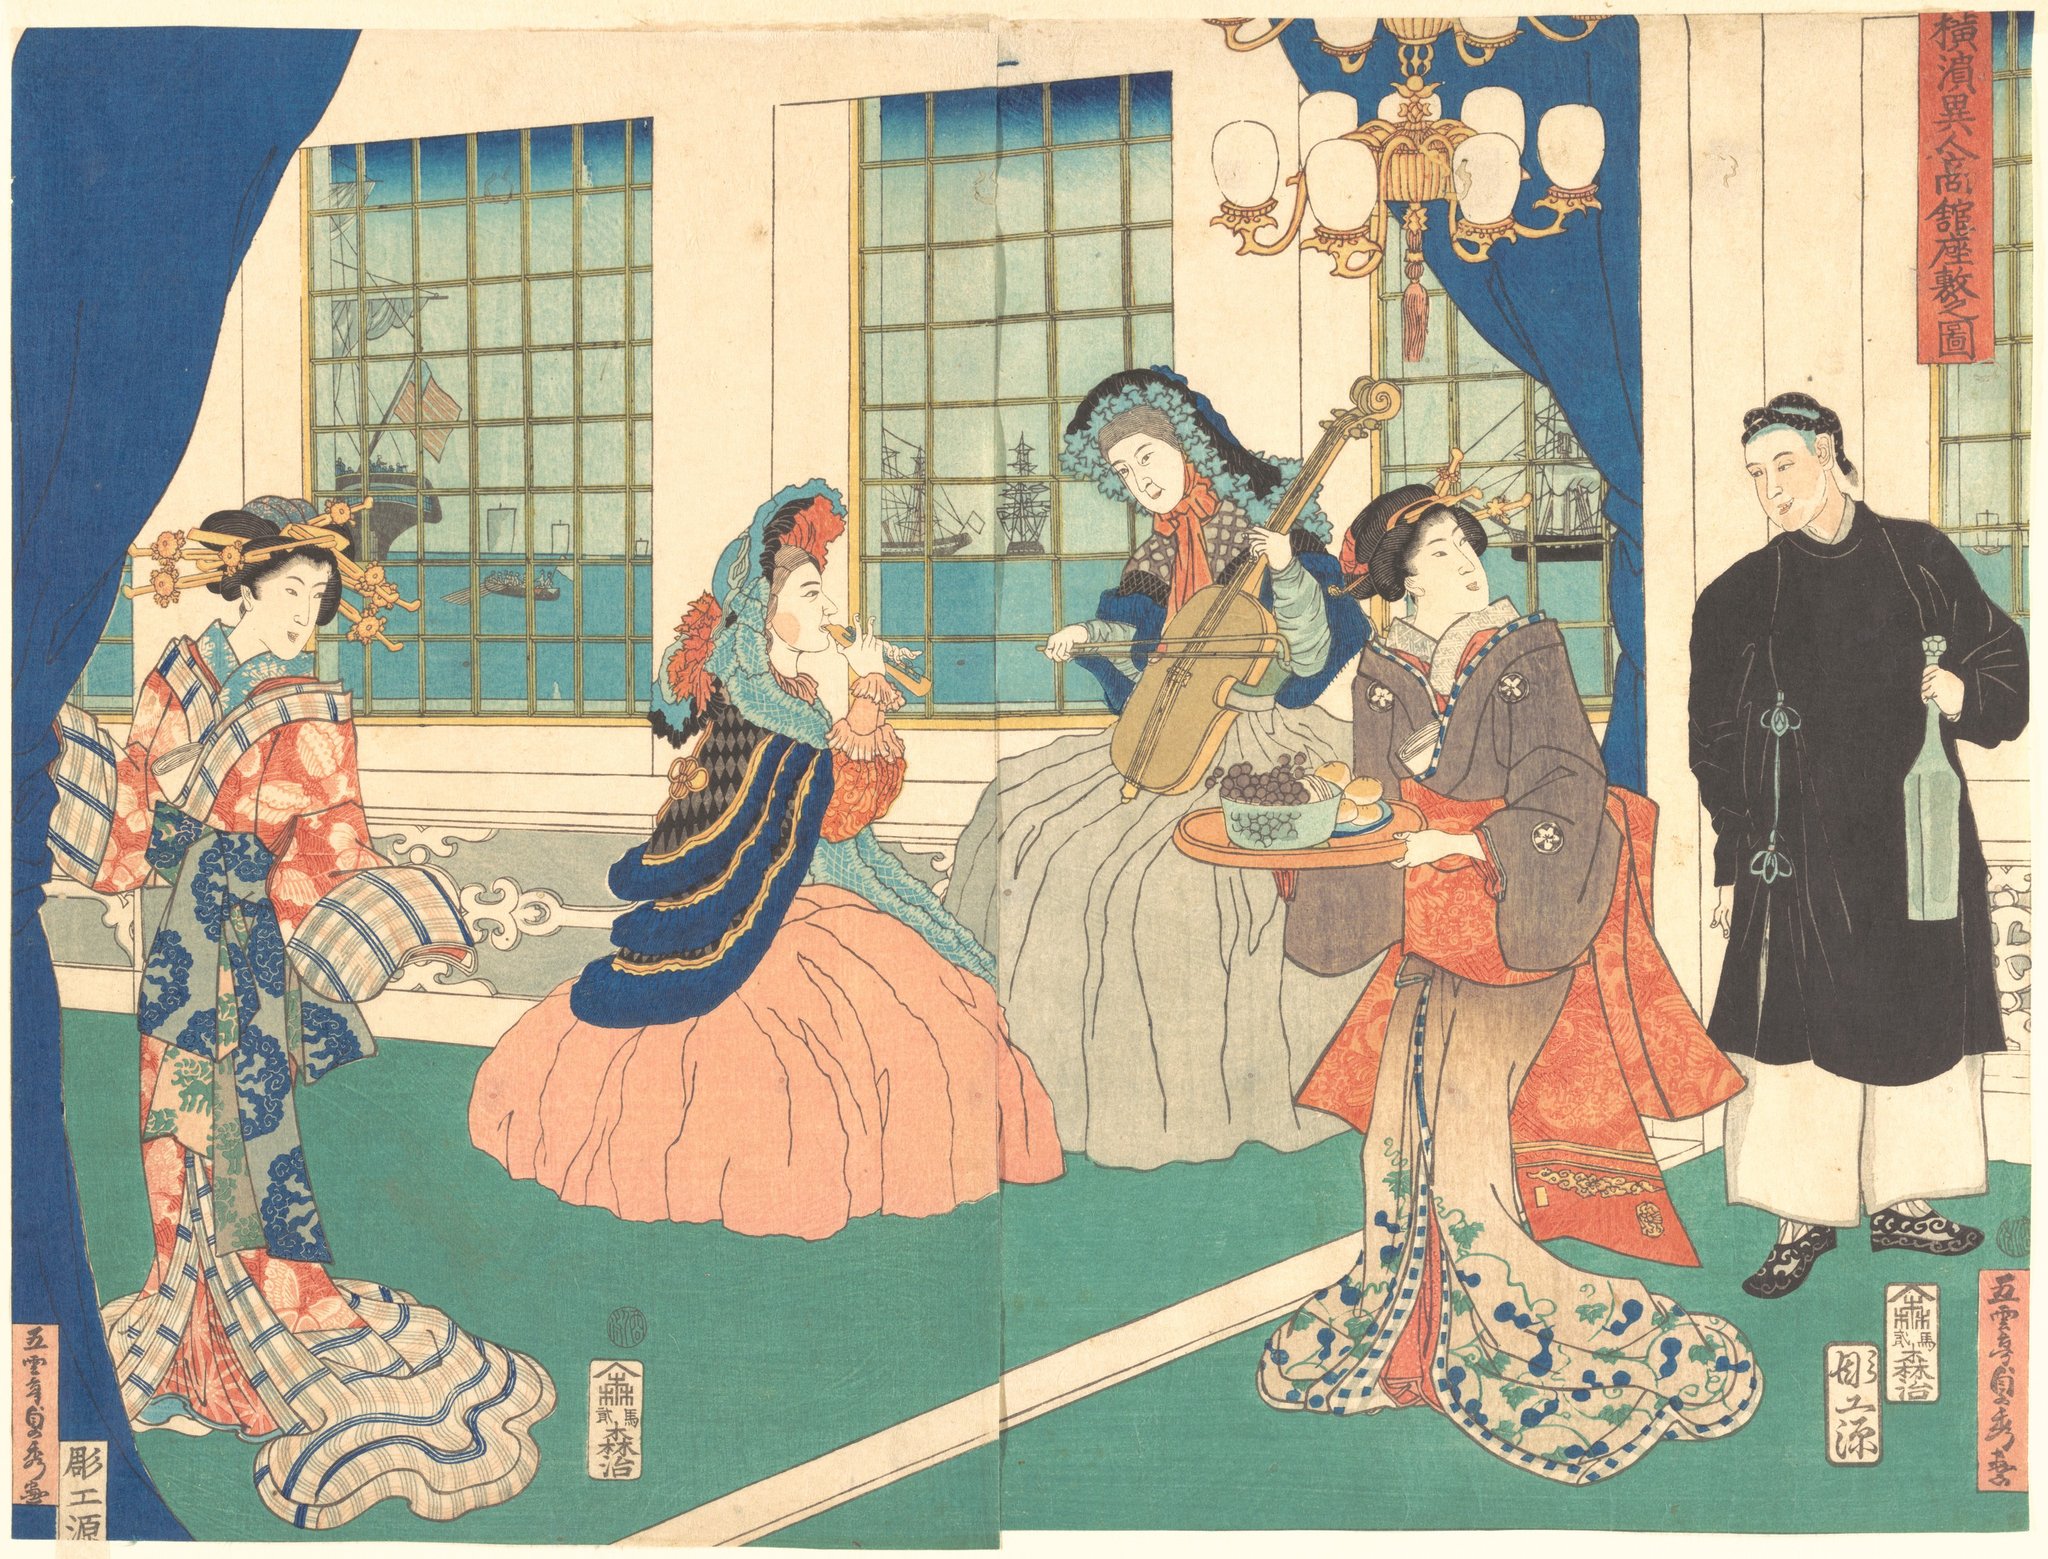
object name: print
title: Yokohama Foreigners in the Sitting Room of a Merchant Ship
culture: japanese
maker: utagawa (gountei) sadahide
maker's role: artist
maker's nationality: japanese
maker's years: 1807-1873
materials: ink, panel, paper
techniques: woodblock print